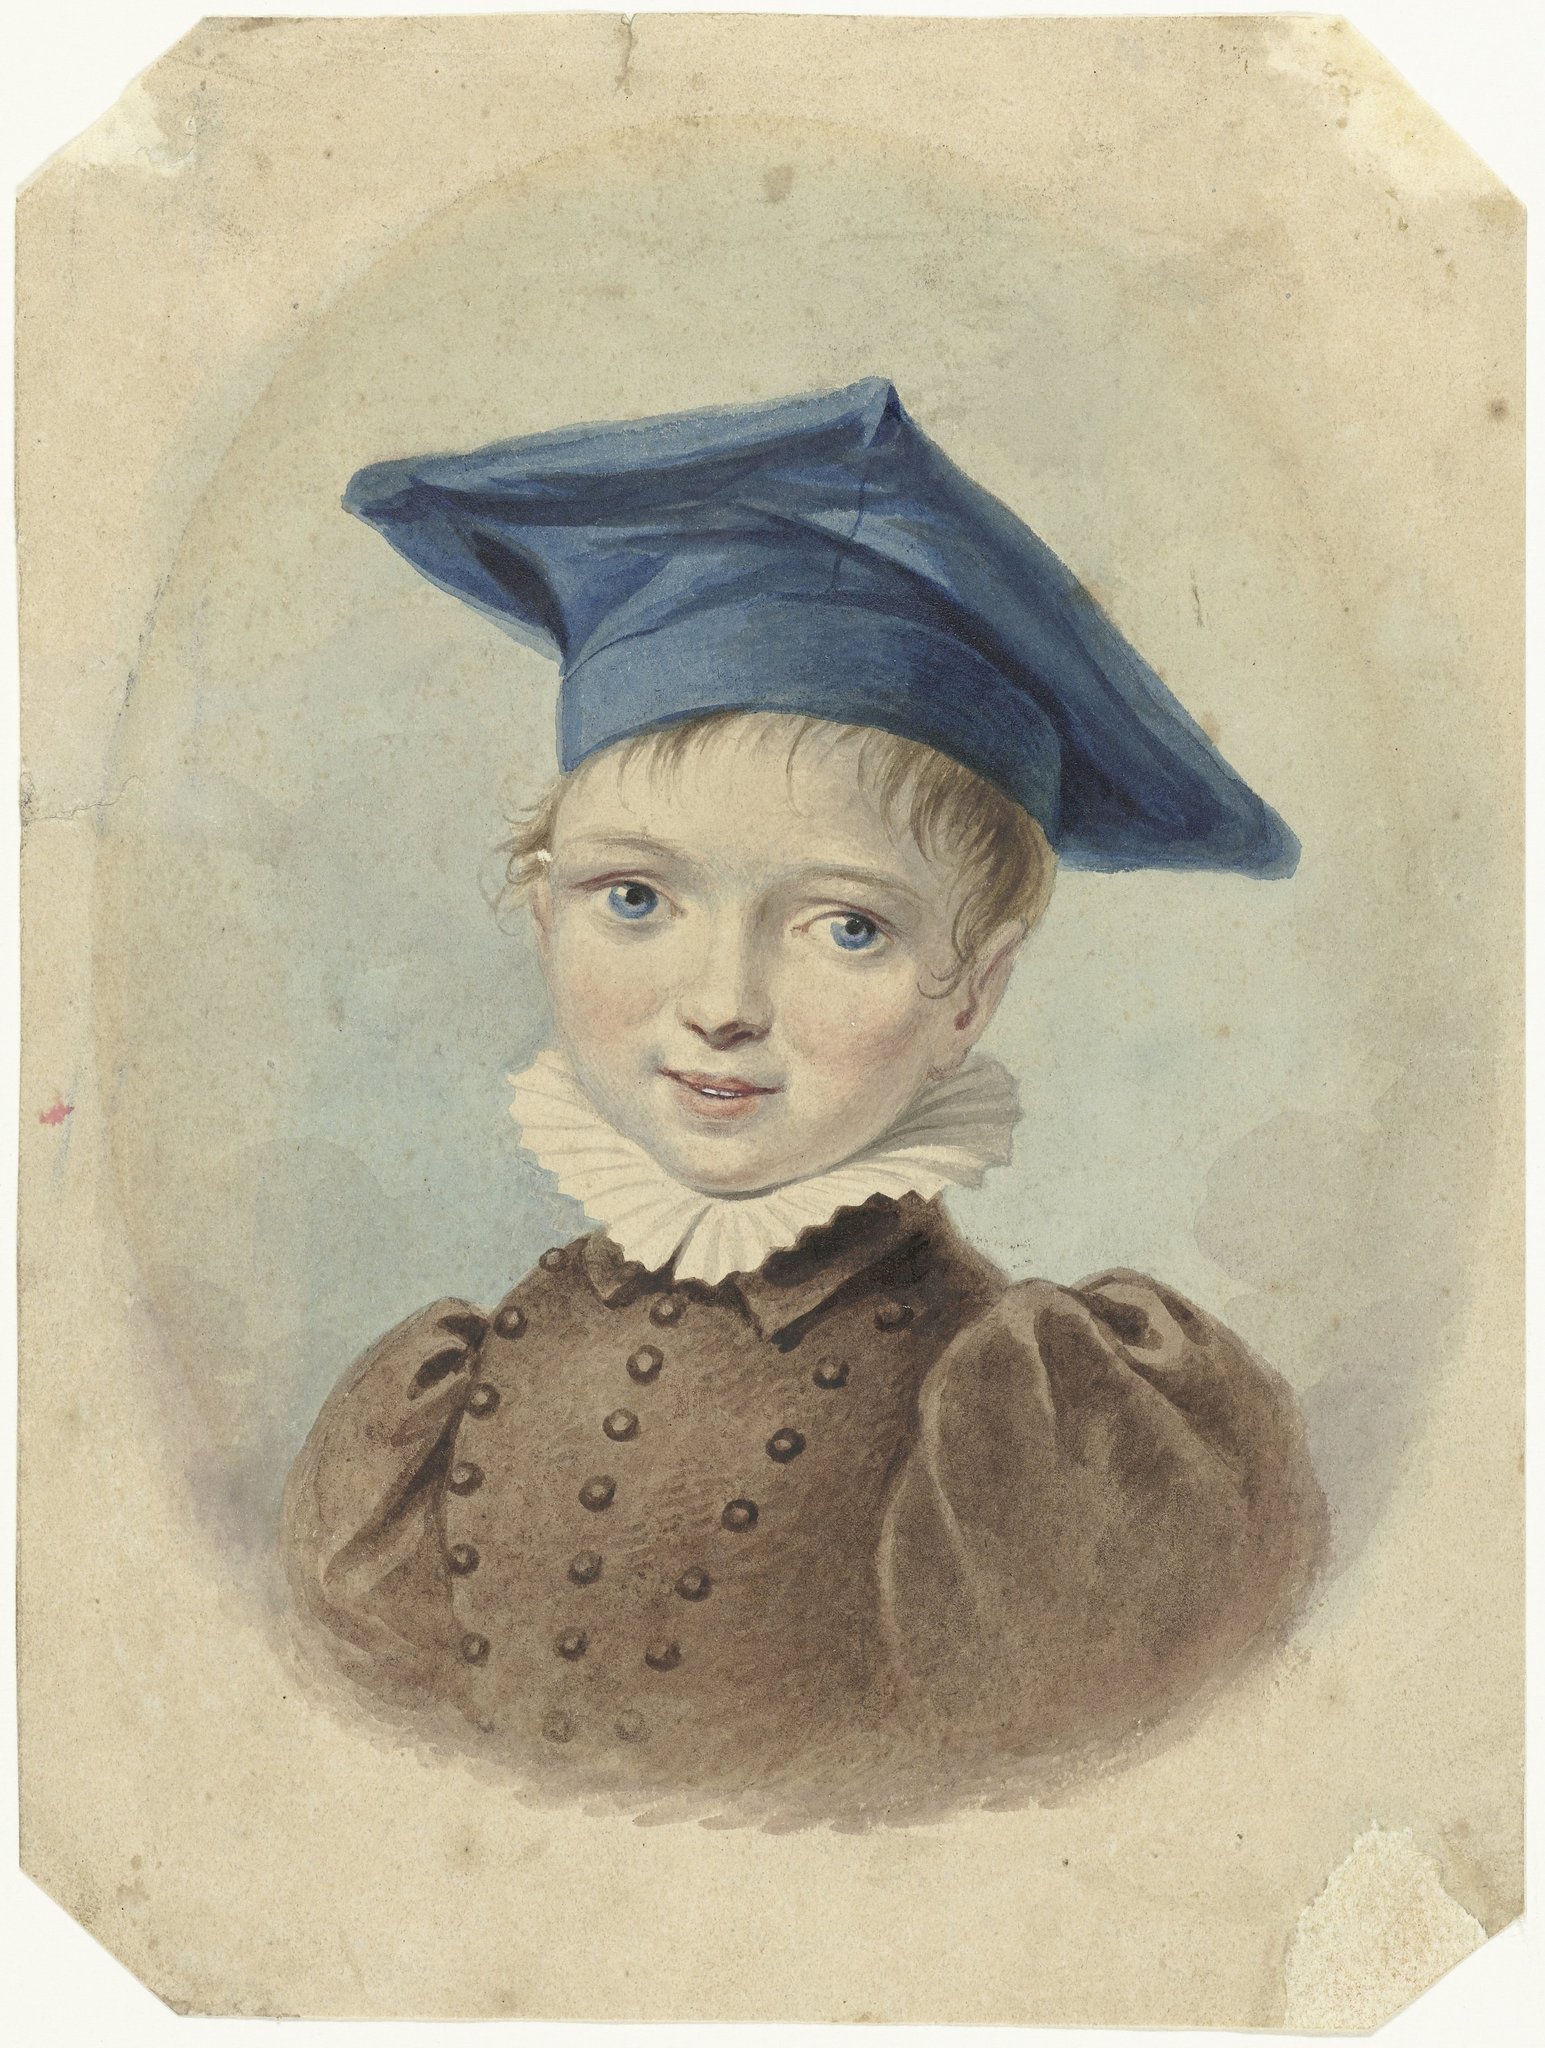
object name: watercolor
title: Jongetje met een blauwe baret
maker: johannes hari (i)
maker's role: draughtsman, painter, print maker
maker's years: 1772-1849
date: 1782-1849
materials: paper, pencil, watercolor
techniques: brush